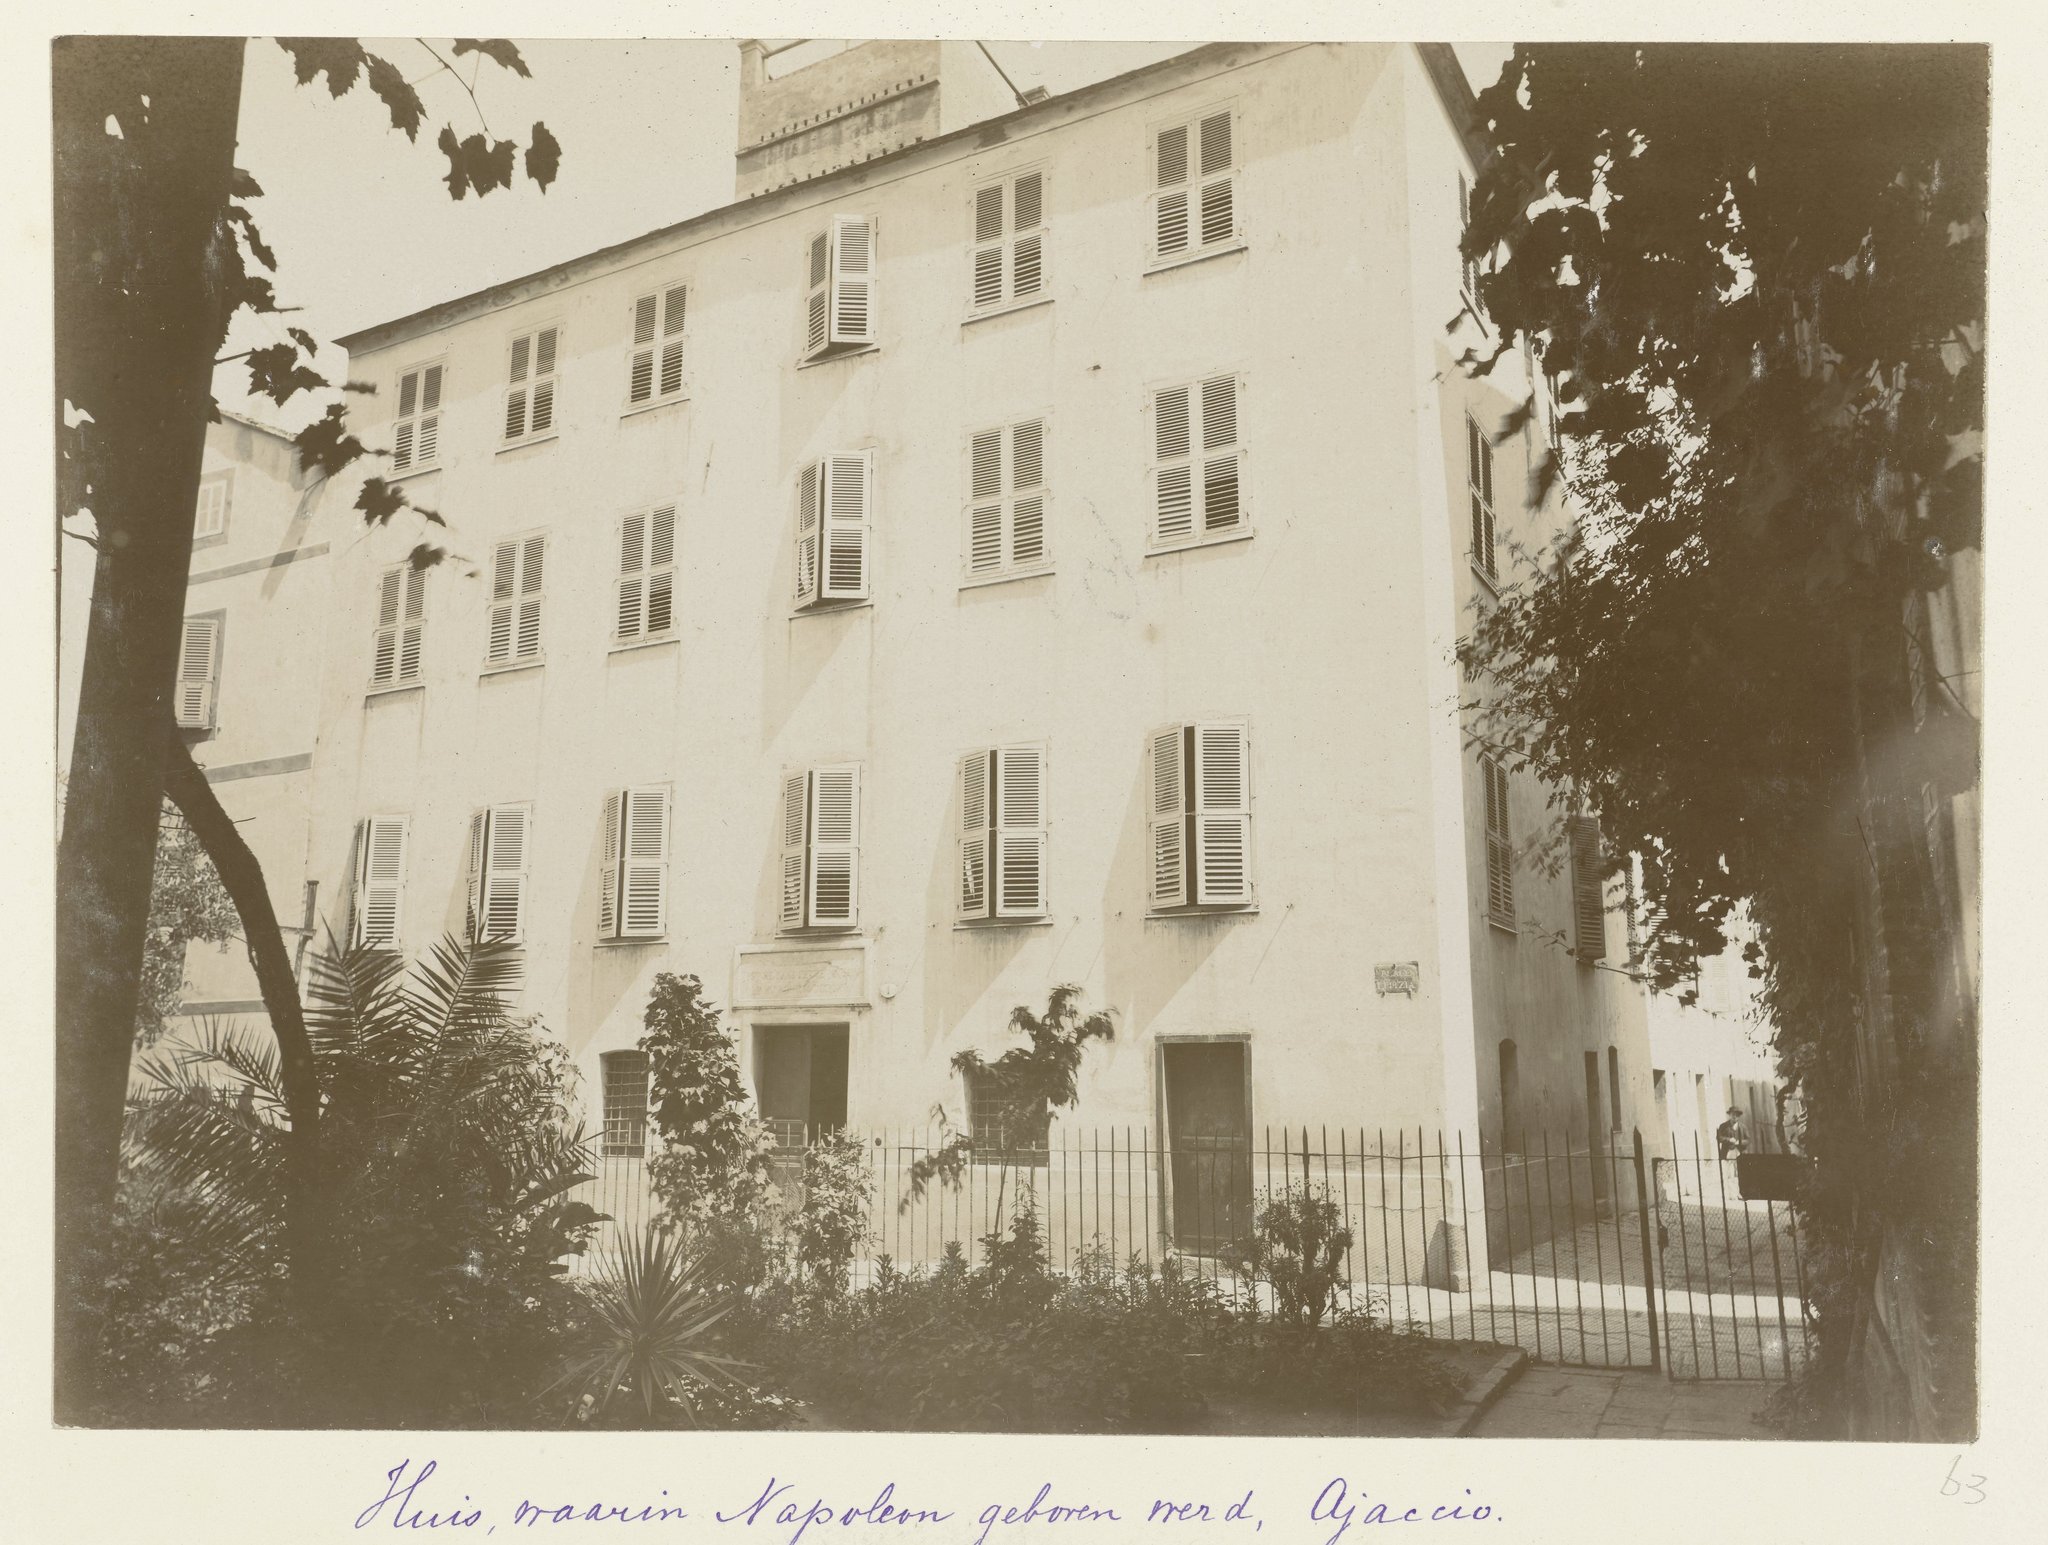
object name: photograph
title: Napoleon Bonaparte's geboortehuis in Ajaccio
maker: henry pauw van wieldrecht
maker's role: fotograaf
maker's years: 1863-1912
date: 1886-1896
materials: cardboard, photographic support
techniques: albumen print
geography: corsica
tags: ajaccio